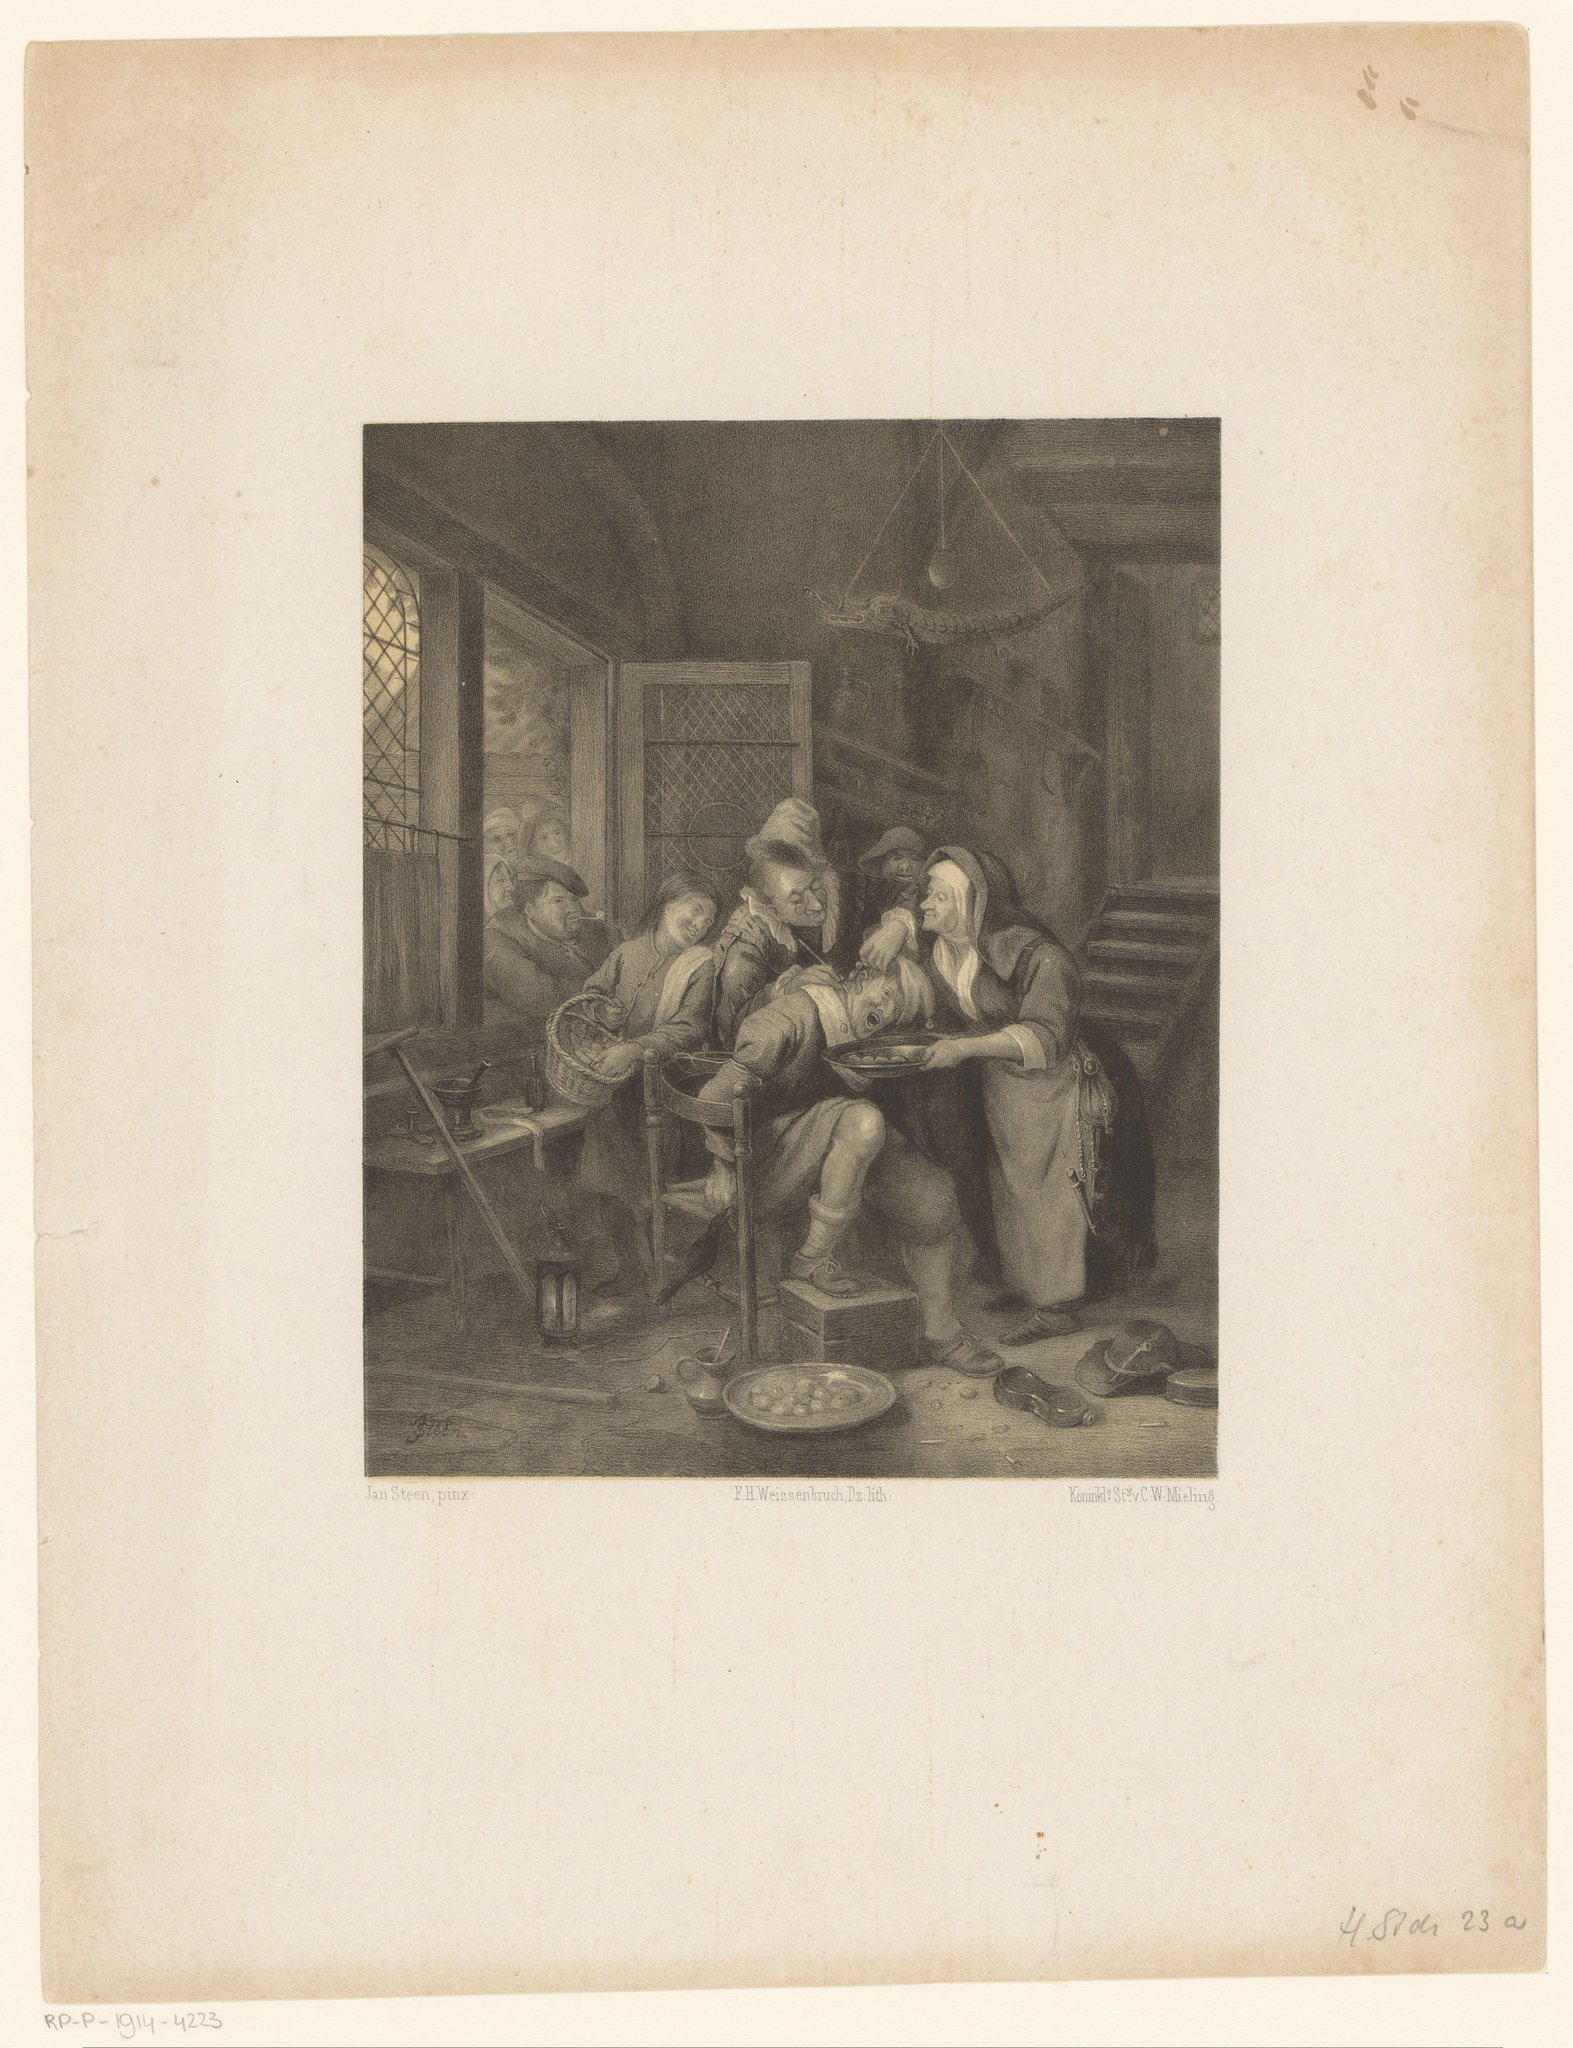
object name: print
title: Keisnijder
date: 1858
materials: paper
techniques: tone lithography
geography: the hague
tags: stone-operation, e.g.: by the witch of malleghem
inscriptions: collector's mark: Lugt 2228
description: Een man zit vastgebonden op een stoel. Achter hem staat een kwakzalver die de keien uit zijn hoofd verwijdert. Een vrouw rechts met een schaal vangt de keien op. Door de deur kijken toeschouwers buiten naar het tafereel.